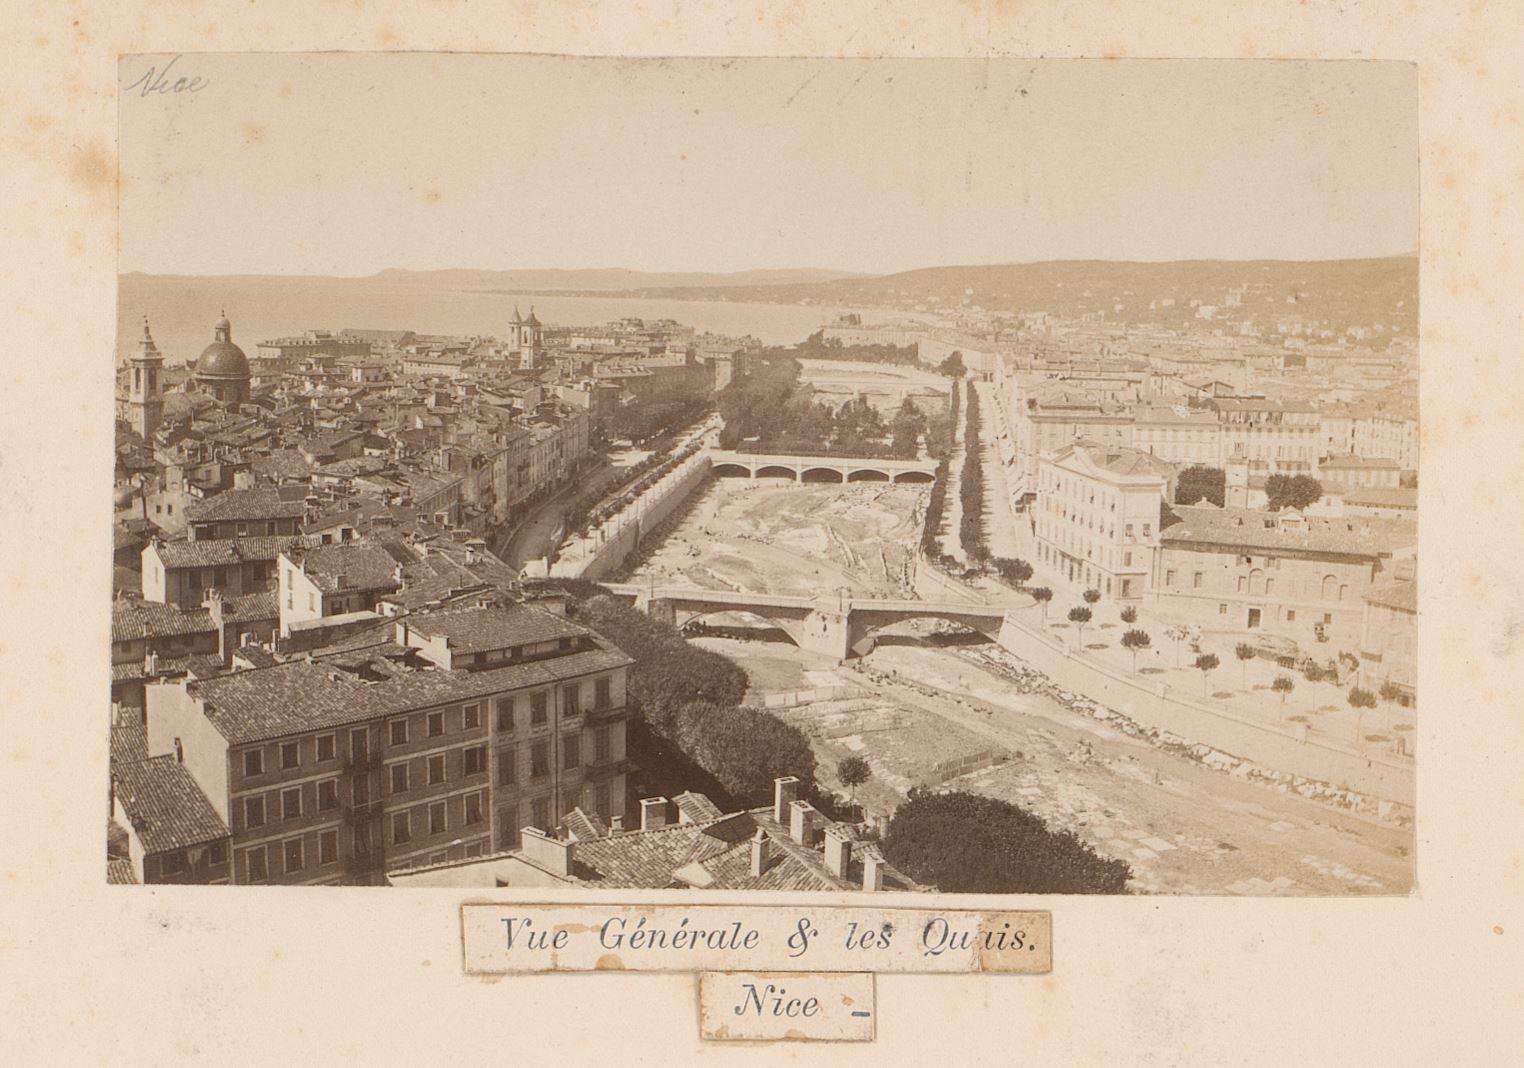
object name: album leaf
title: Gezicht op Nice, Frankrijk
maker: Anonymous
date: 1875-1880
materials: paper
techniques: albumen print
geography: nice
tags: city-view in general; 'veduta', river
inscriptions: inscription: ‘Nice’